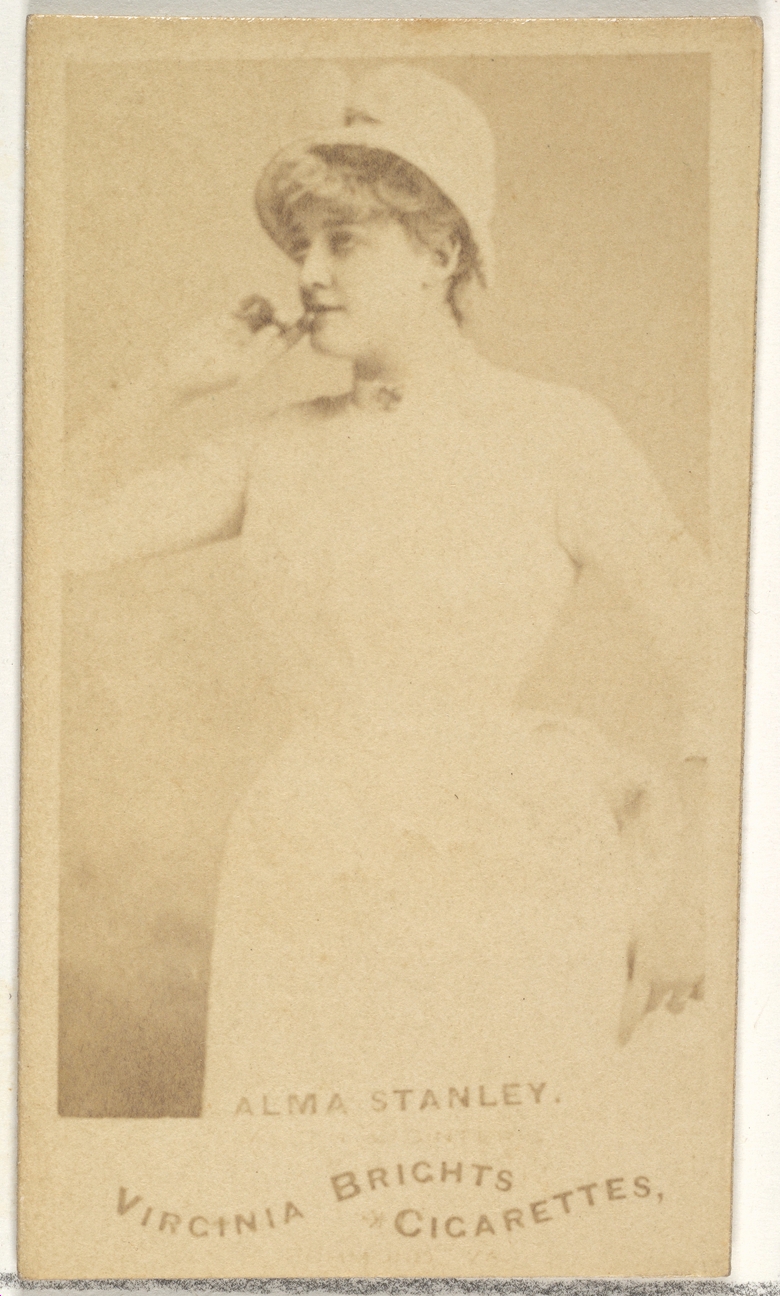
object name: photograph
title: Alma Stanley, from the Actors and Actresses series (N45, Type 1) for Virginia Brights Cigarettes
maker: allen & ginter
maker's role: publisher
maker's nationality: american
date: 1888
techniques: albumen silver print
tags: portraits,women,actresses